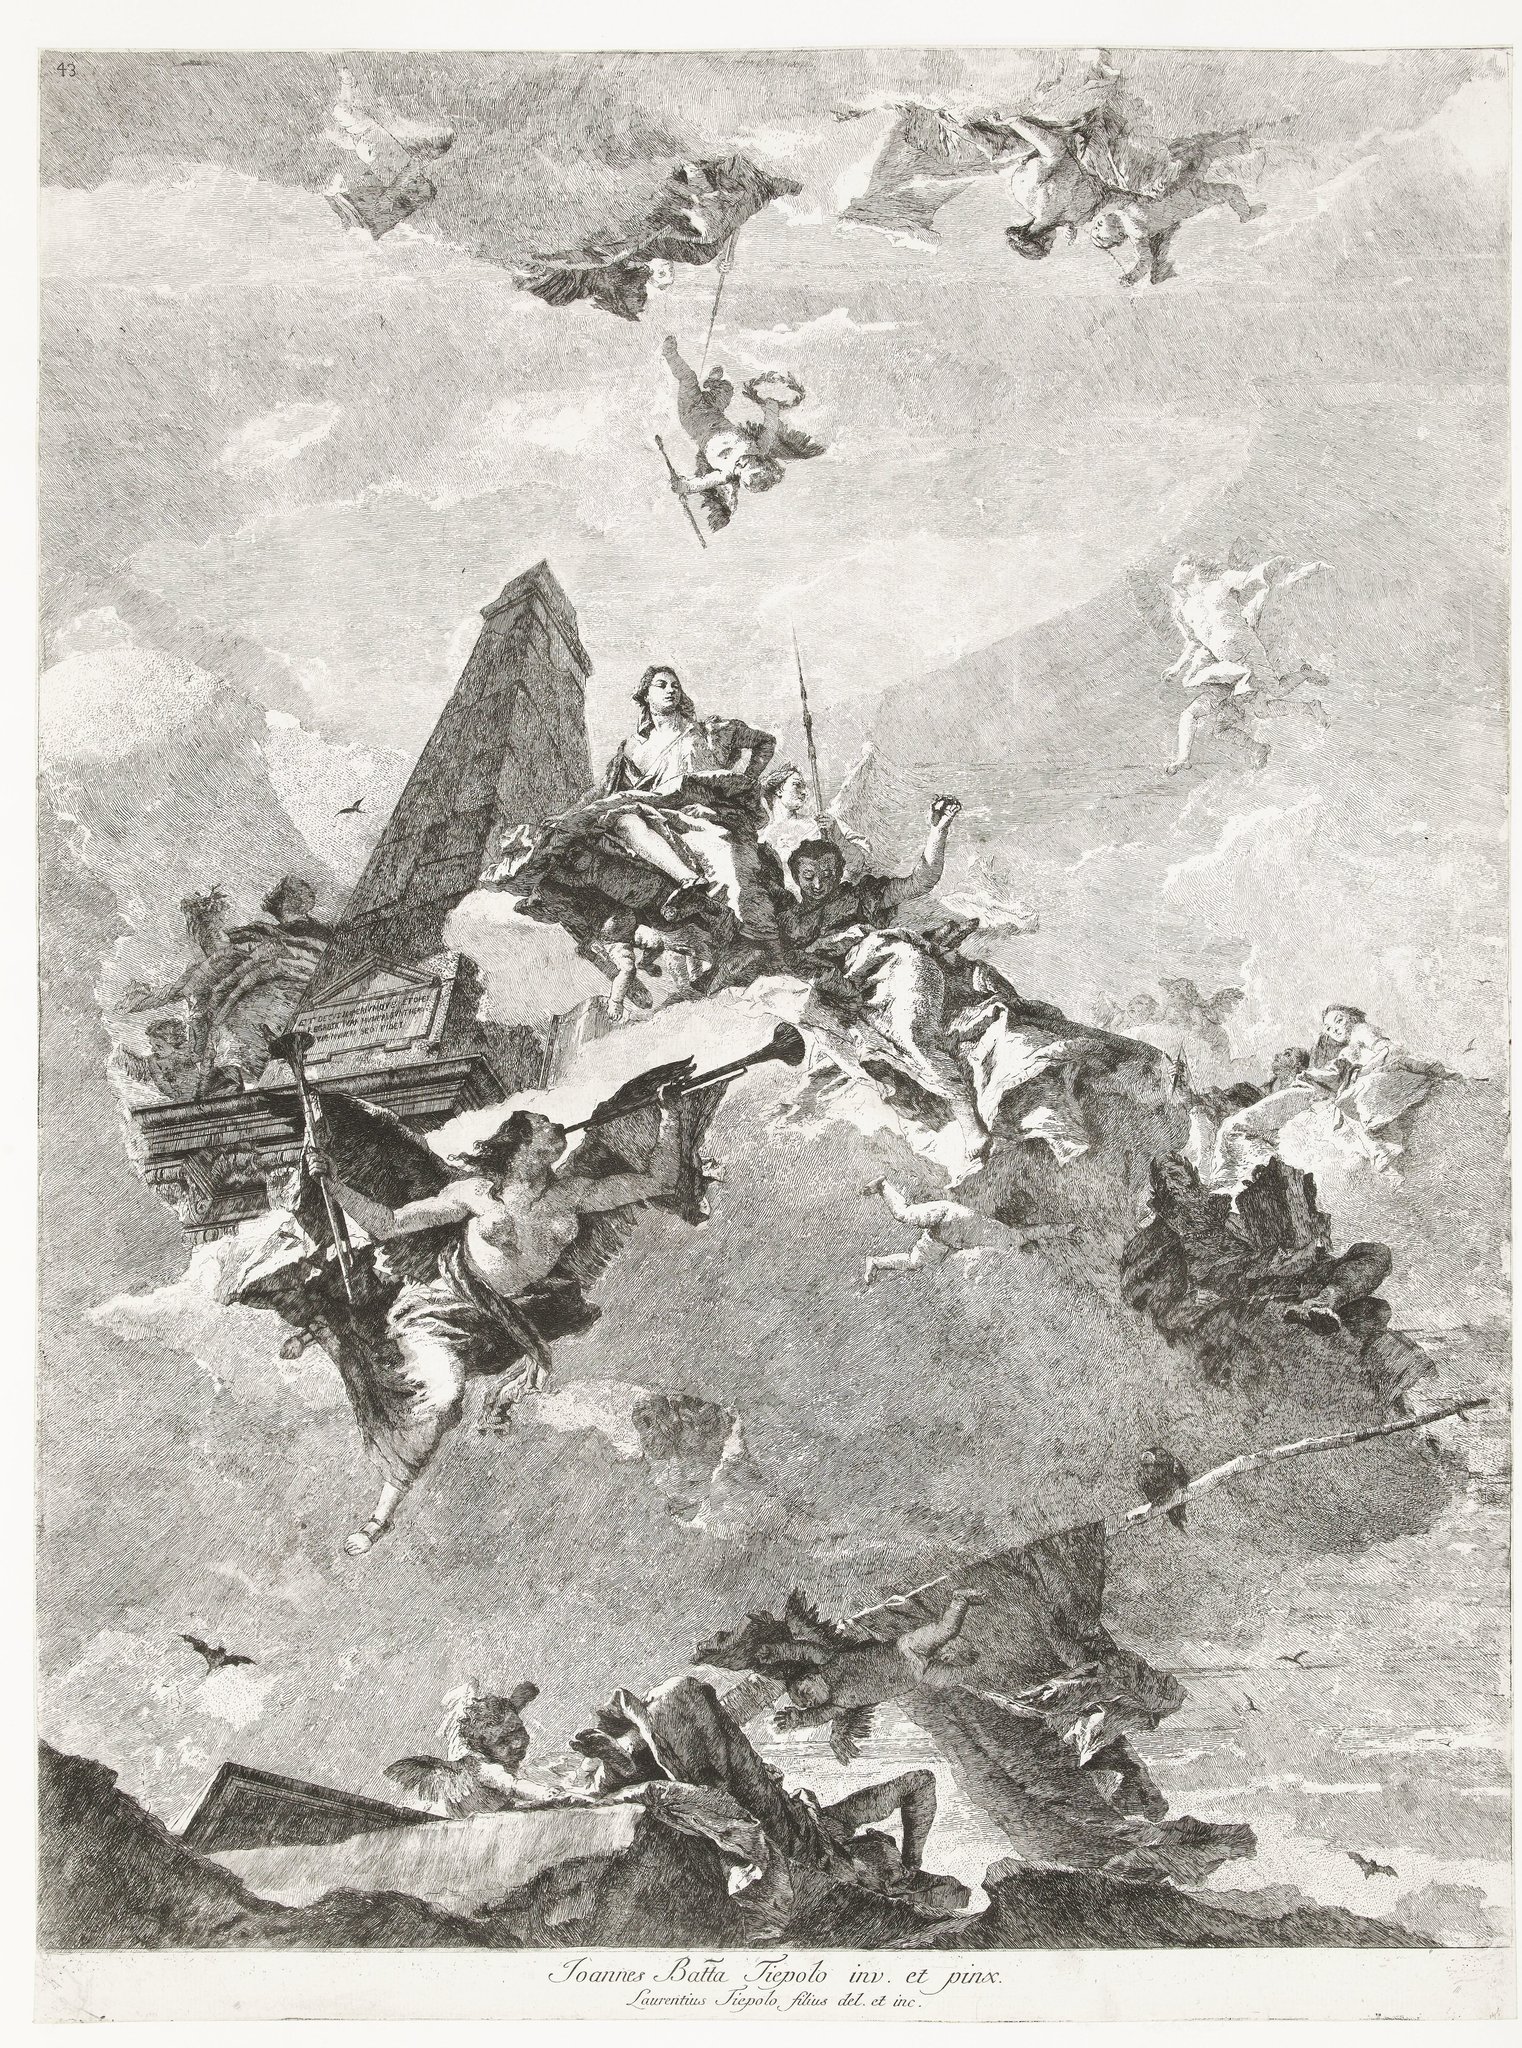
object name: print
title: Plafondschilderingen te Sint Petersburg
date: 1757-1761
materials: paper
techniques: etching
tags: magnificence; 'magnificenza' (ripa), fame; 'fama', 'fama buona', 'fama chiara' (ripa)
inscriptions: collector's mark: Lugt 2228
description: Prent naar plafondschildering te Sint Petersburg door Giovanni Battista Tiepolo. Prent uit serie van vier prenten naar deze plafondschilderingen waarvan één van de hand van Giovanni Domenico Tiepolo (zowel schildering als ets).